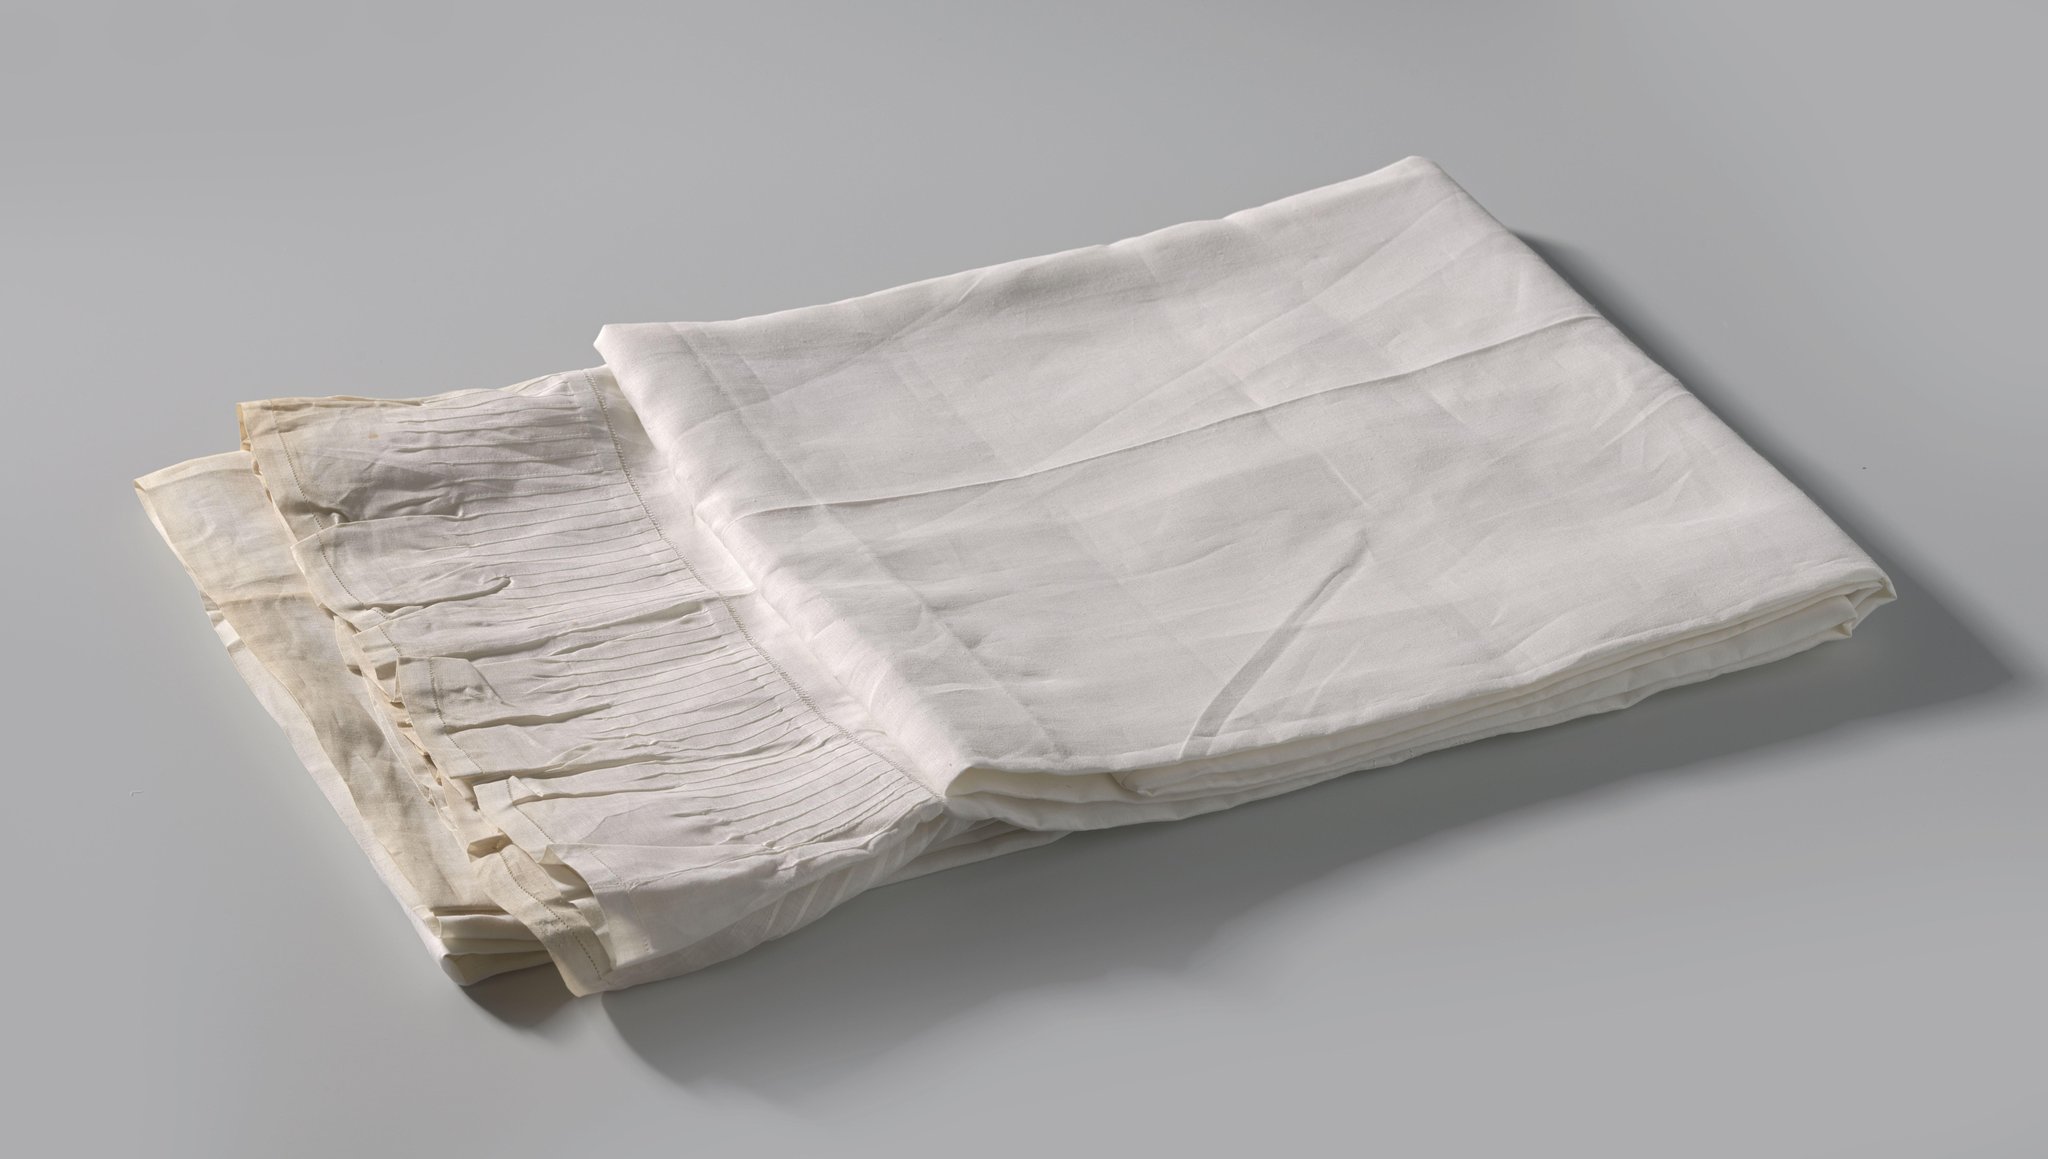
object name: beddenlaken, laken object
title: Laken van linnen met aan de bovenzijde aangezette geplooide strook, geappliceerde bladeren en de initialen BU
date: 1935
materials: linen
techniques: embroidered, weave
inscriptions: initials: ‘BU’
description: Laken van linnen in platbinding, met aan de bovenzijde een aangezette geplooide strook. Een deel van de zijden en de onderzijde heeft een open zoom. De bovenzijde is versierd met geappliceerde bladeren en een inzet met de initialen BU (Brusse-Urtebise).